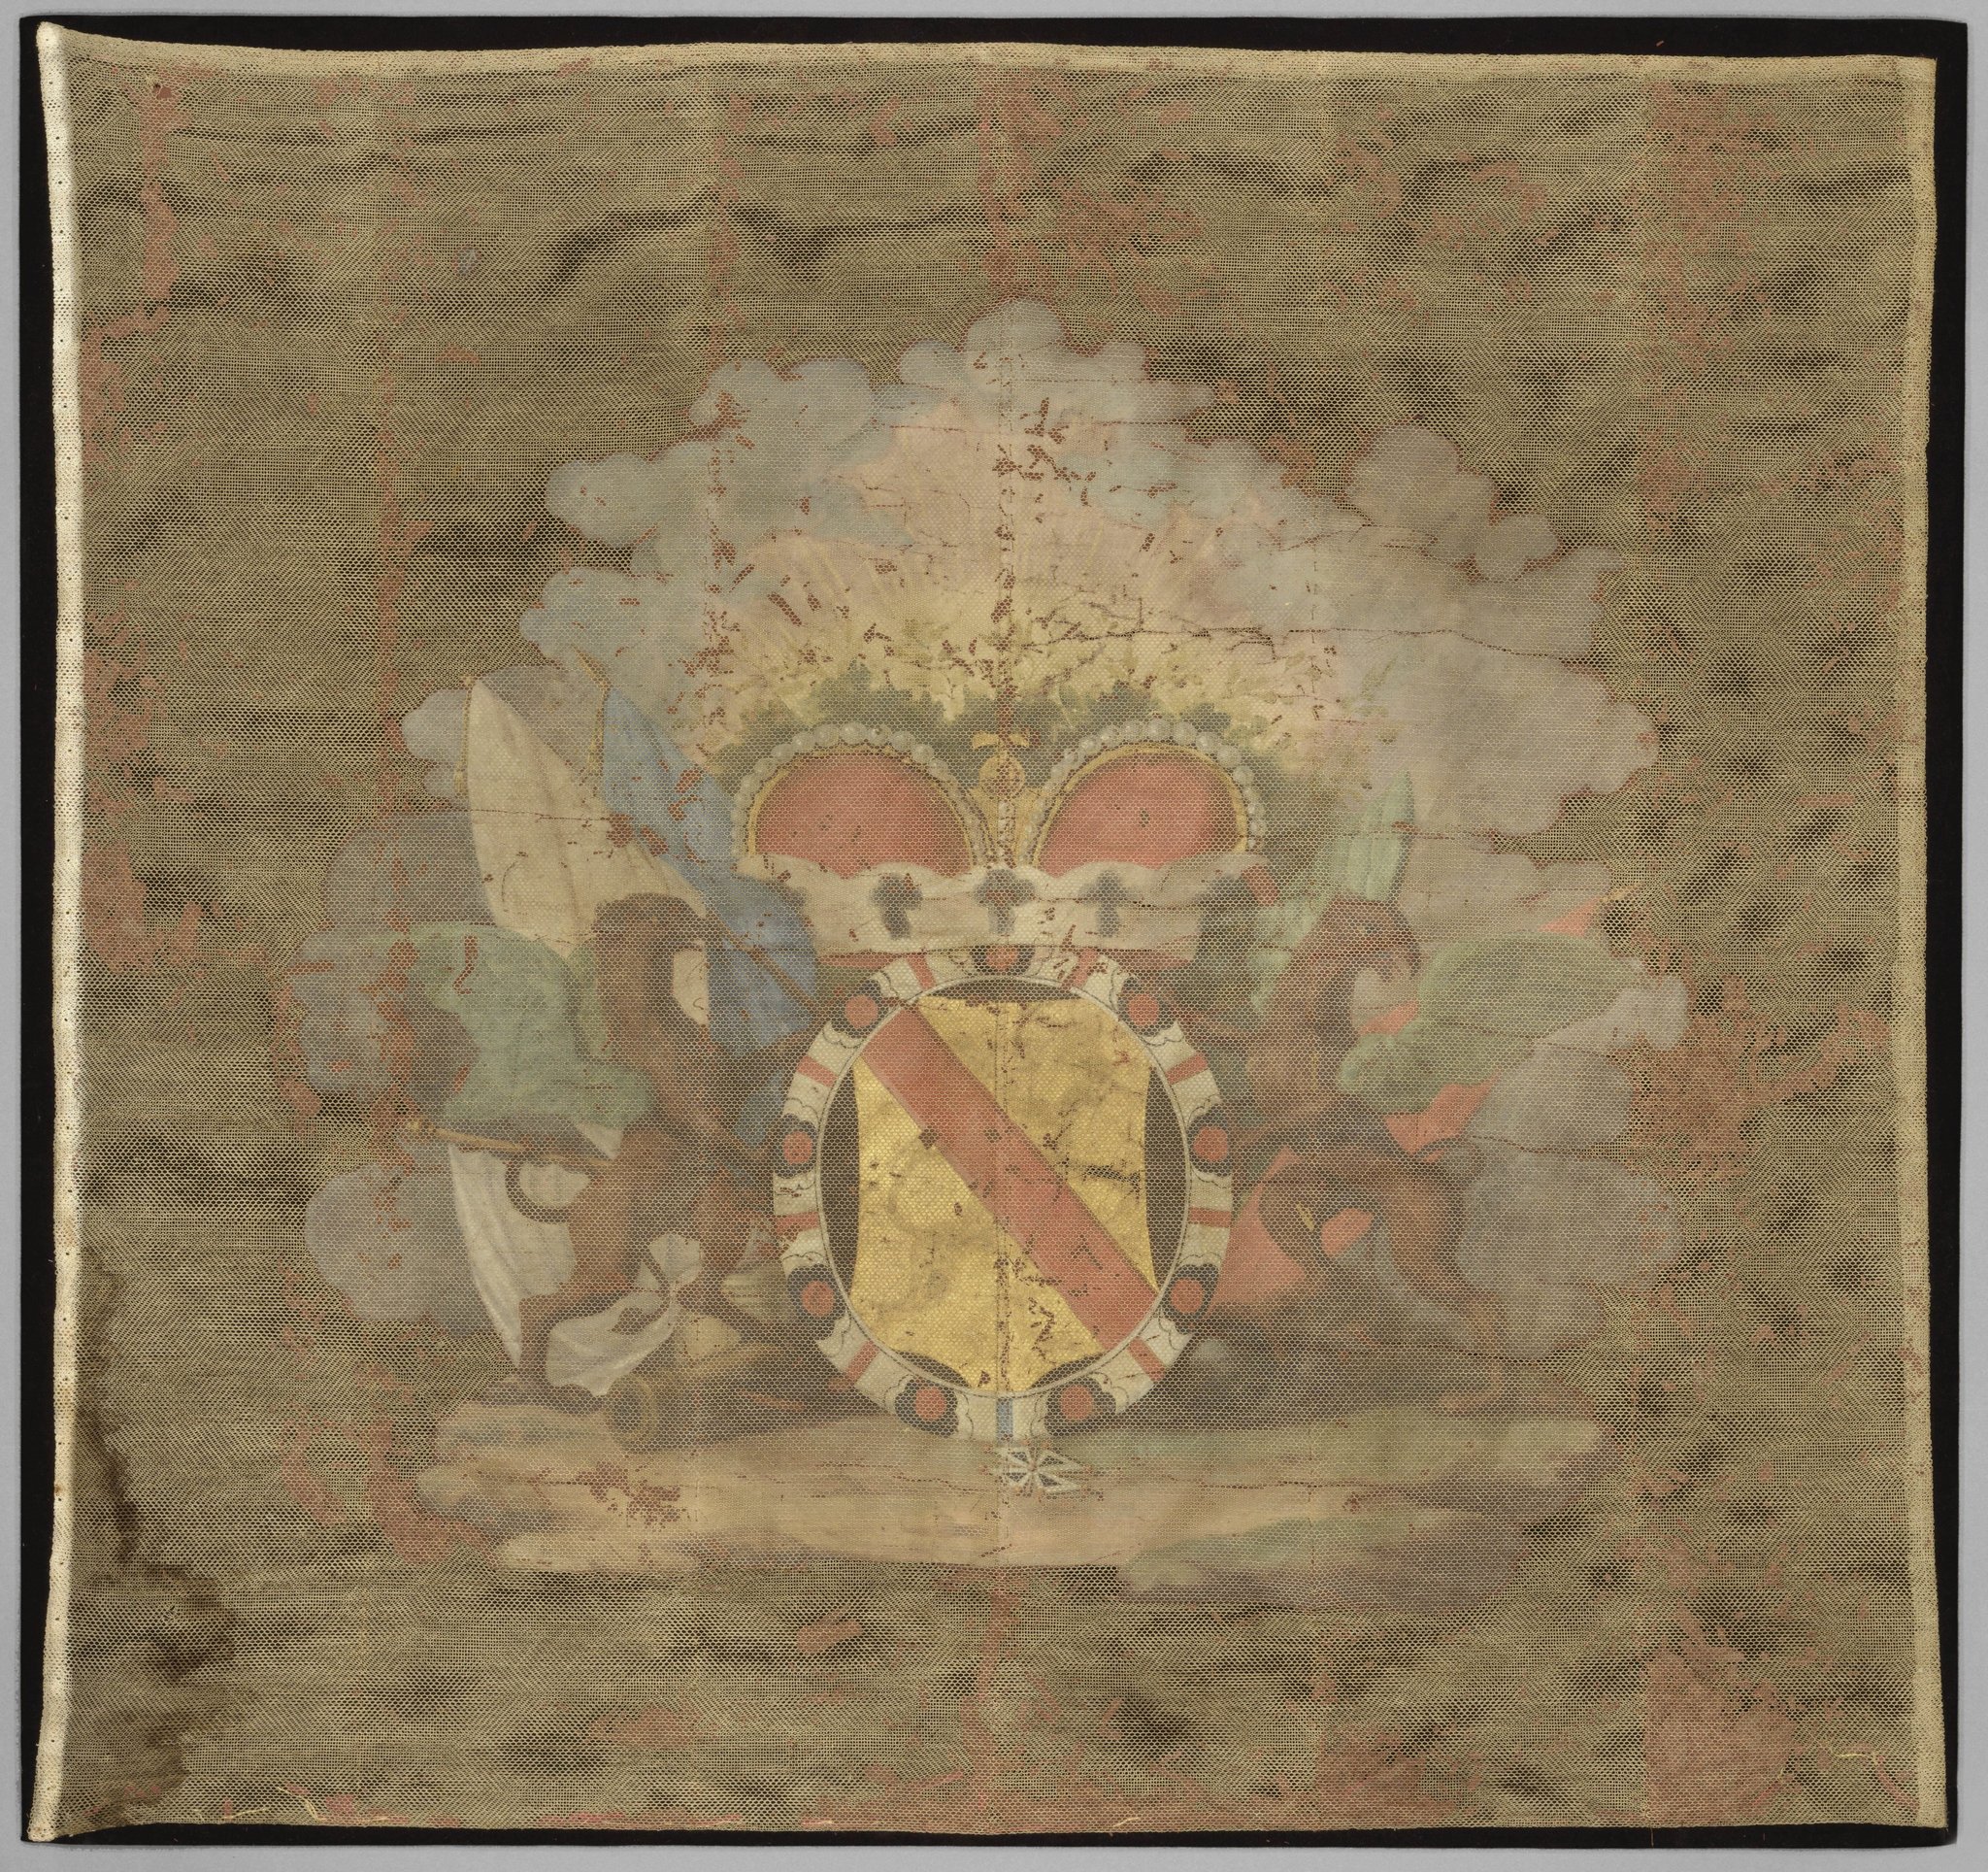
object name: banner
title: Vaandel van een der regimenten Baden-Durlach (vermoedelijk)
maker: Anonymous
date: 1747-1788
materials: paint, silk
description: Rood, op het midden het wapen van Baden, gedekt door vorstenkroon, omgeven door een wit, rood en zwart versierde band. Het geheel wordt gehouden door twee griffioenen (aan vluchtzijde afgewend), en is geplaatst op een trofee van vaandels, kanonnen enz.; achter de kroon een groene bosschage, waarachter zonnestralen en een wolkenpartij. Op de voorgrond ligt schuin aan de vluchtzijde een kruisvormig ordeteken. Paradekant: in plaats van het wapen van Baden het wapen van de Republiek. De ovale band eromheen is blauw waarop: CONCORDIA RES PARVAE CRESCUNT, gedekt door een kroon met drie geparelde beugels en rode muts. Aan weerskanten een gaande leeuw. Het geheel is geplaatst op een trofee van vaandels, trommels, kanonnen, kogels, geweren enz. Op de achtergrond een bosschage met zonnestralen en wolken als voorkant.